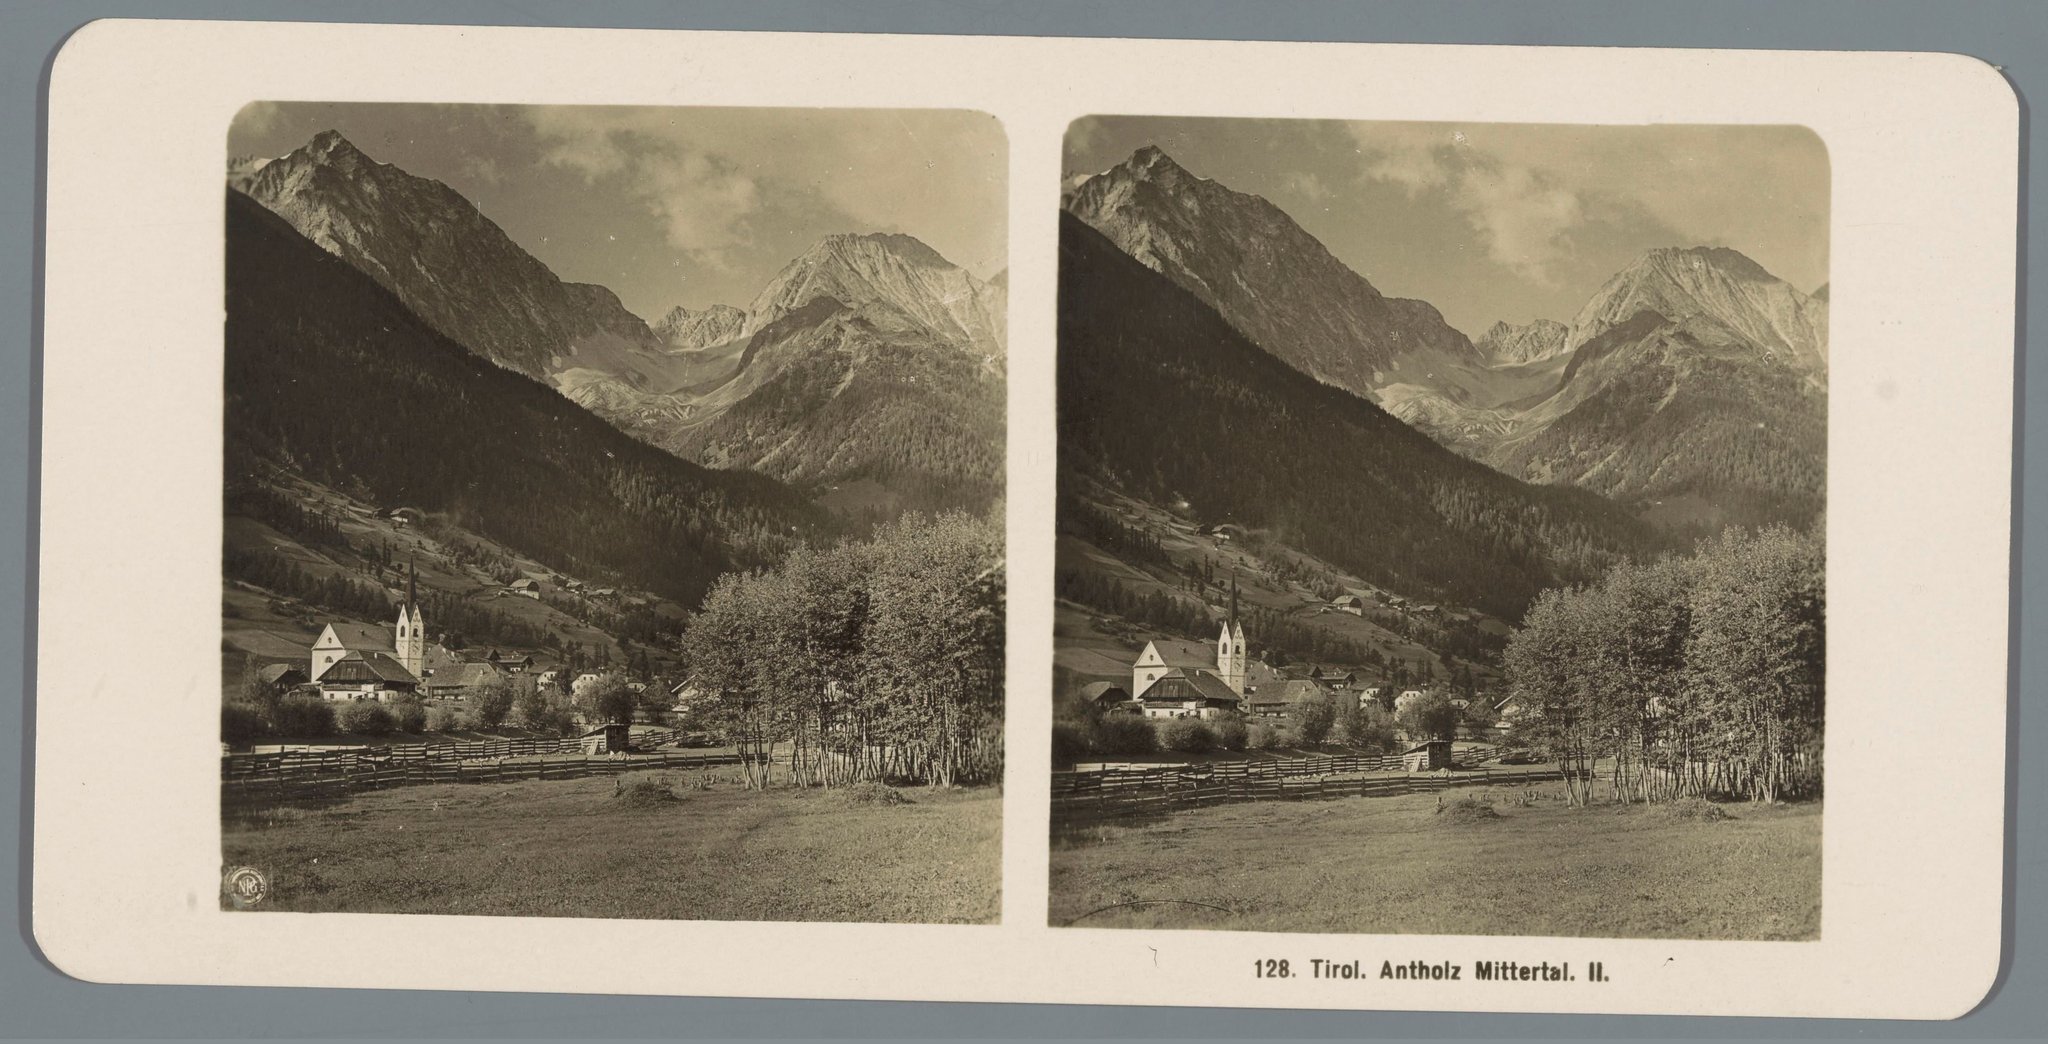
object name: stereograph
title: Gezicht op Anterselva di Mezzo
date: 1900-1910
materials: cardboard, photographic support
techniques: gelatin silver print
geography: tirol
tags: dale, valley, city-view in general; 'veduta', mountains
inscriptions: inscription: ‘NPG’, number: ‘128.’